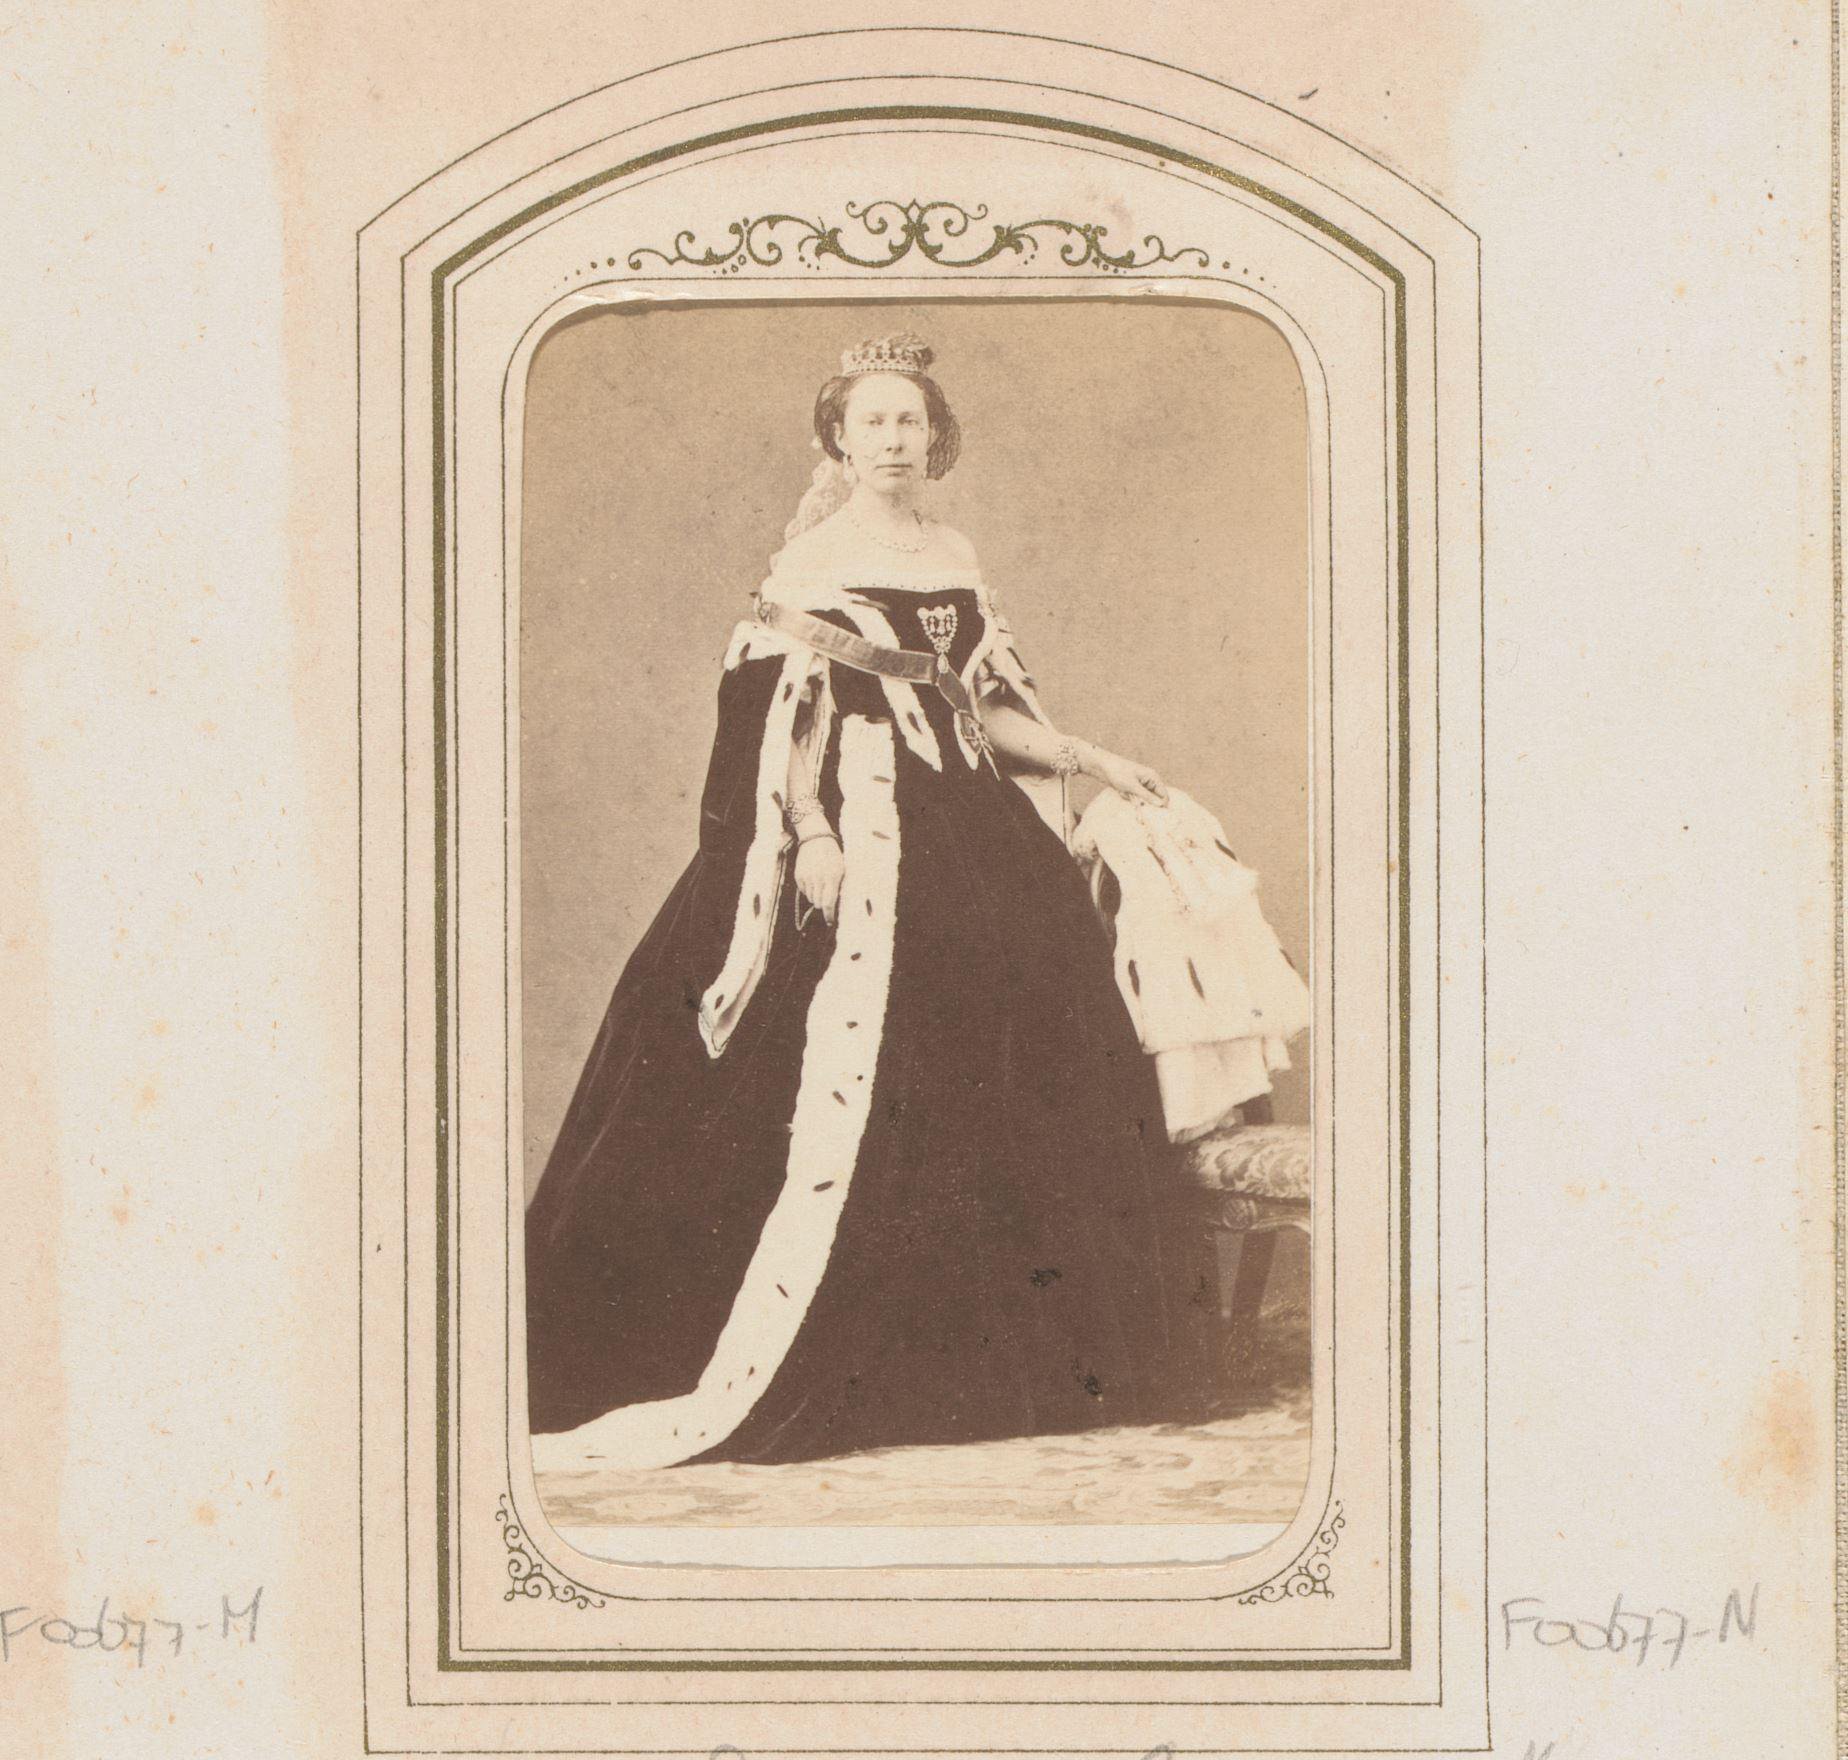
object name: carte de visite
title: Portret van Louise van Oranje-Nassau, koningin van Zweden en Noorwegen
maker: math. hansen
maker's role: fotograaf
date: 1855-1870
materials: cardboard, photographic support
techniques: albumen print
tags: the hague, historical persons - bb - woman, queen, netherlands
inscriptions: annotation: ‘koningin Louise van Zweden en Noorwegen/ geb prinses der Nederlanden’, name: ‘Romj[..] v Schr[...]’, inscription: ‘MATHs HANSEN/ KONGL. HOF-PHOTOGRAF/ Drottninggatan No 5/ STOCKHOLM’